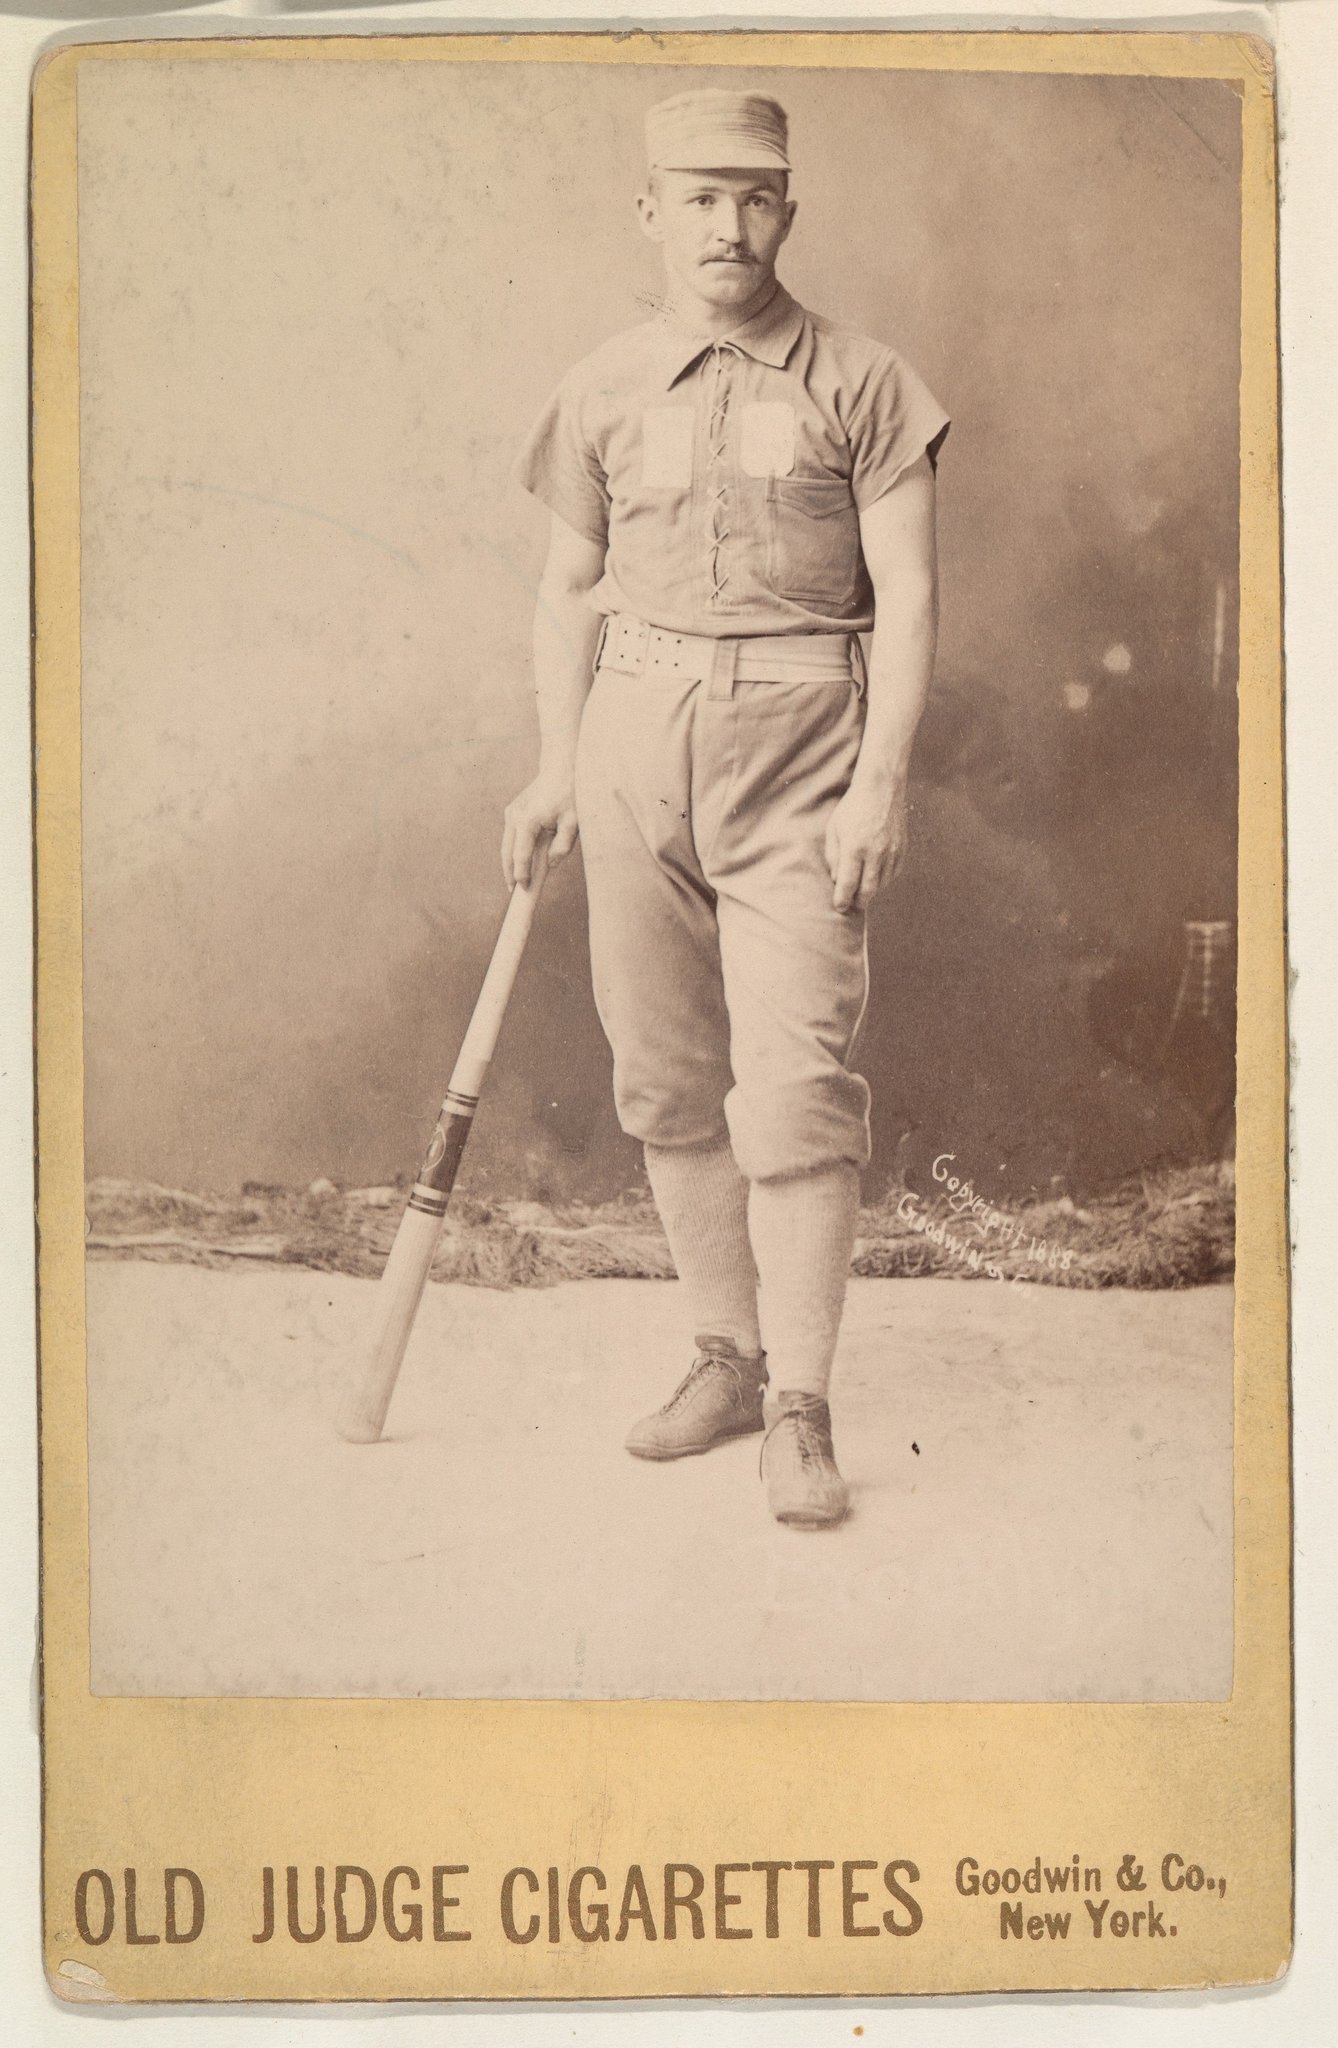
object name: baseball card, photograph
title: Charlie Reynolds, Catcher, Brooklyn, from the series Old Judge Cigarettes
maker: goodwin & company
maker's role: publisher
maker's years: 1850-1950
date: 1887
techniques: albumen print, photography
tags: men,portraits,baseball,athletes